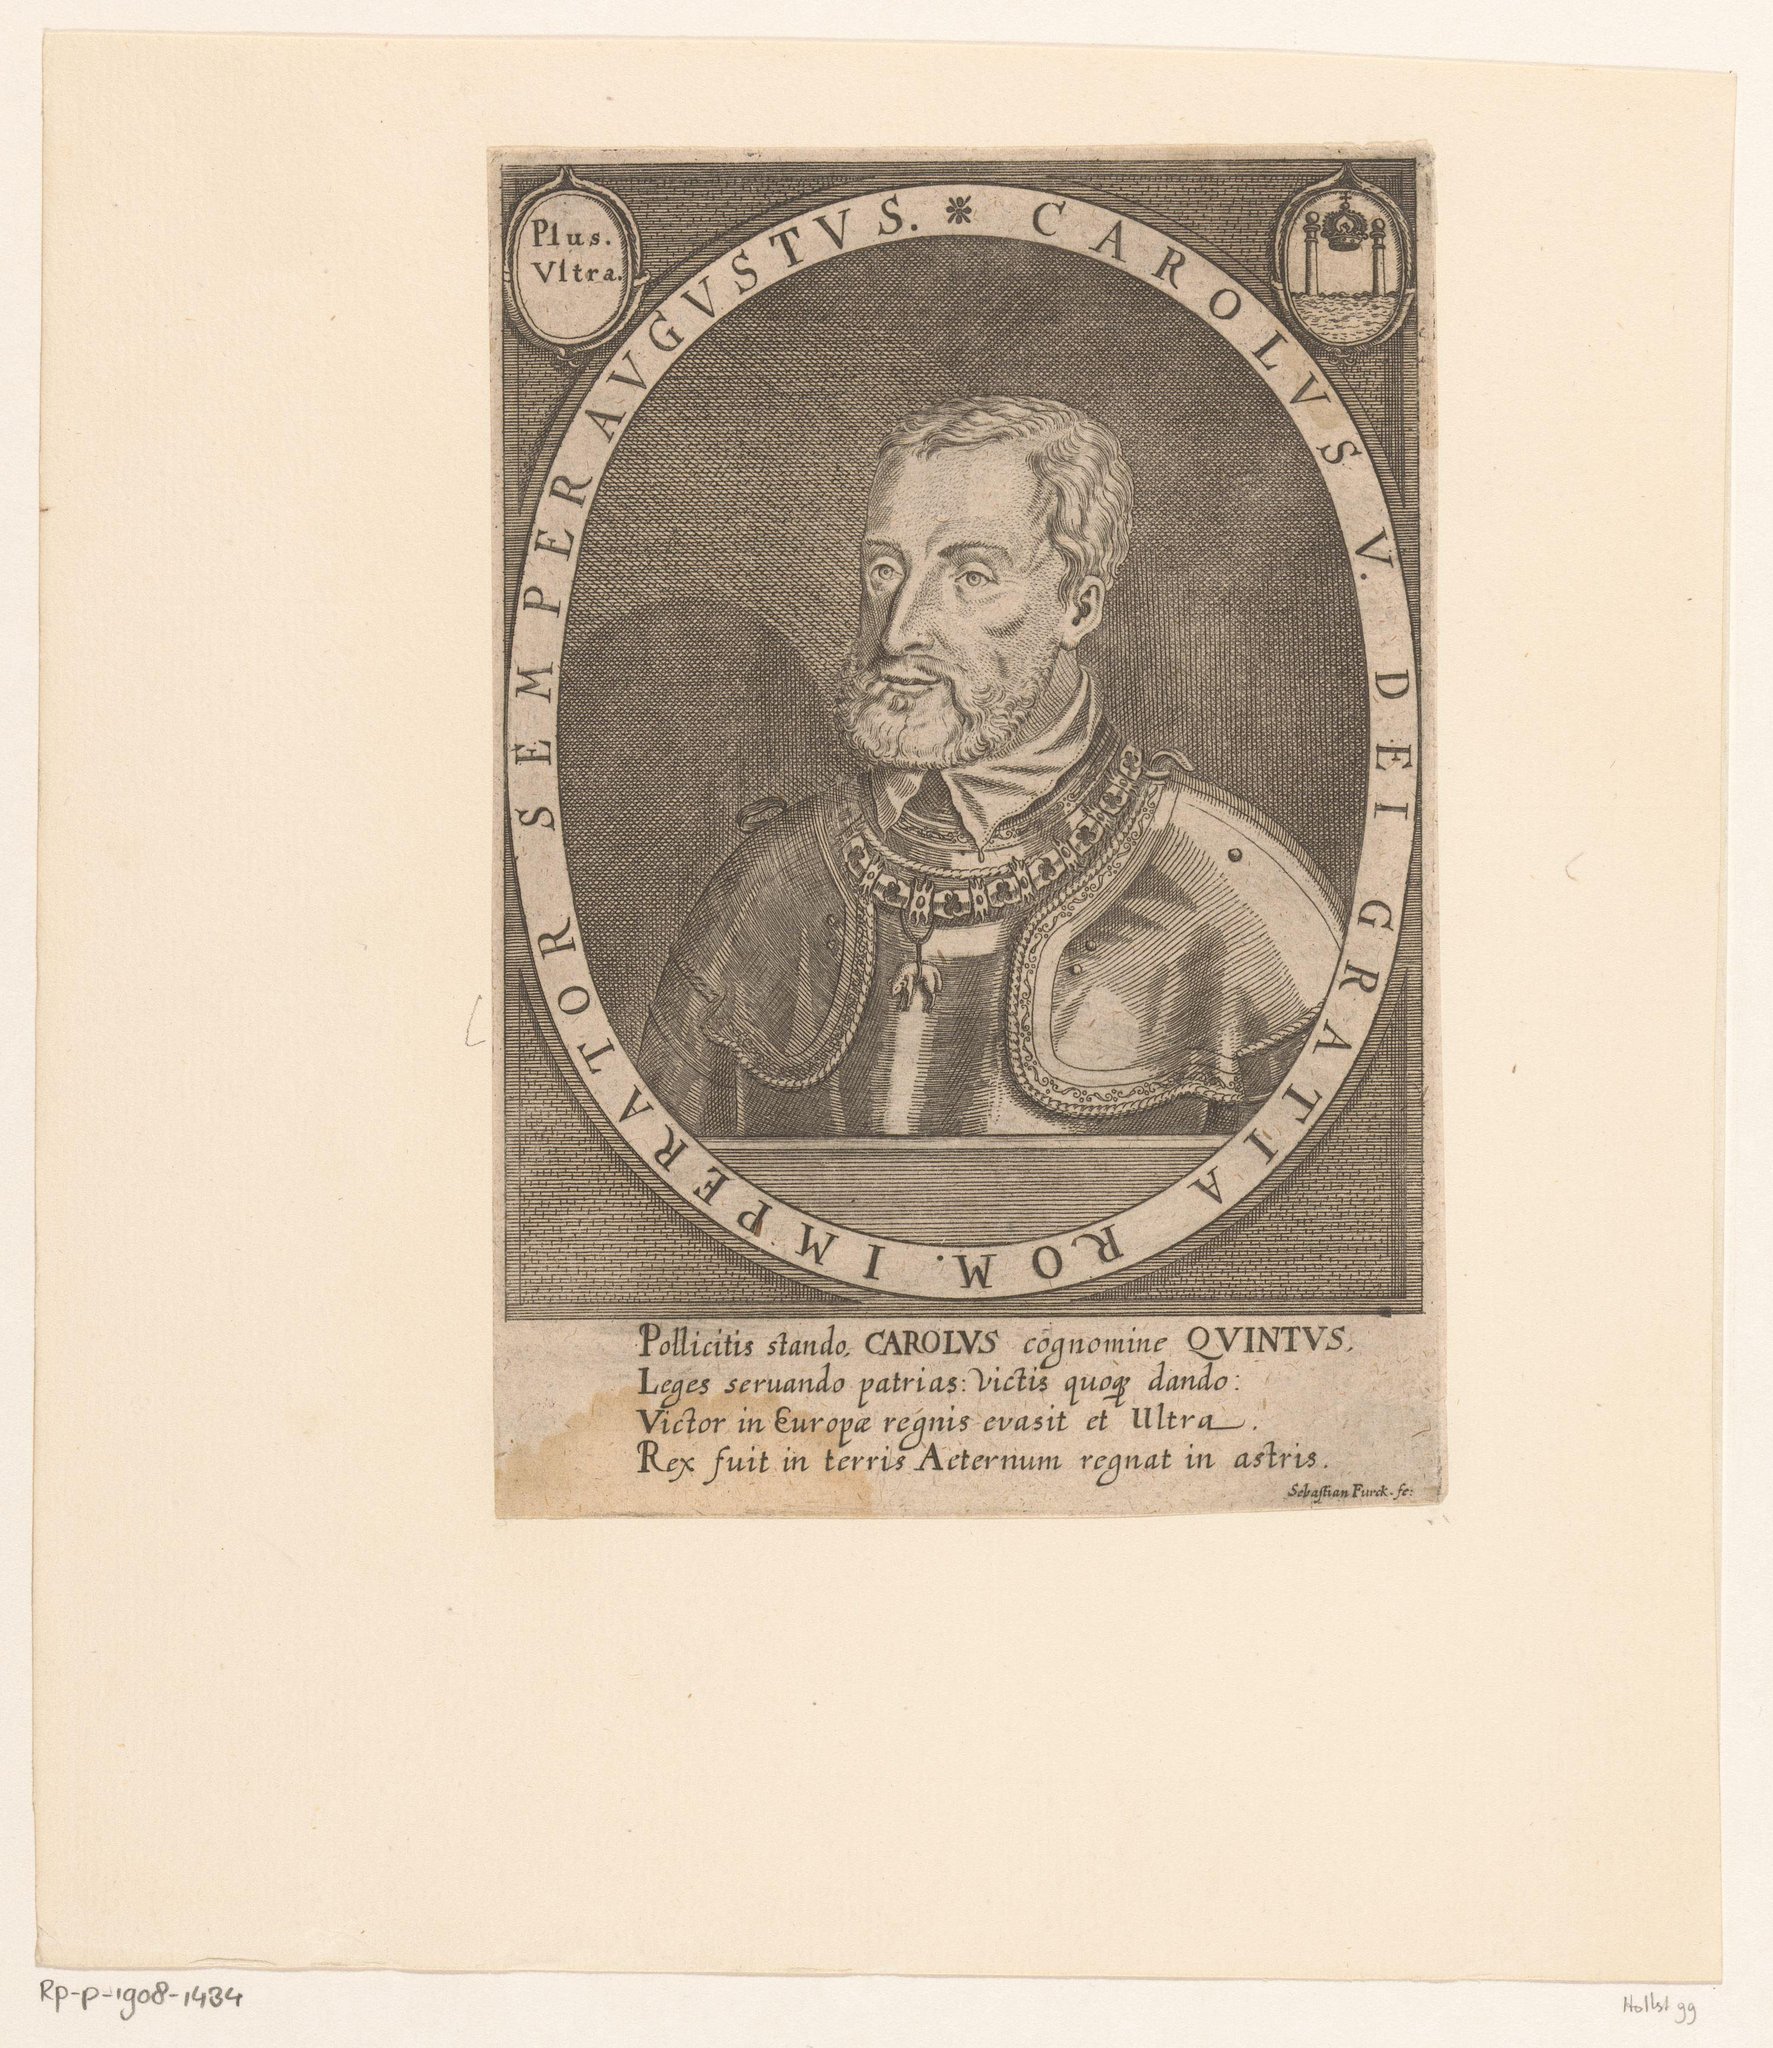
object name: print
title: Portret van keizer Karel V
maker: sebastian furck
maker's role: print maker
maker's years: 1600-1655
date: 1641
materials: paper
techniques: engraving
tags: ghent, charles v (holy roman emperor and king of spain), historical persons, emperor, knighthood order of the golden fleece - insignia of a knighthood order, e.g.: badge, chain (with name of order), abstract ideas and concepts (+ emblematical representation of concept)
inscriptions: collector's mark: Lugt 2228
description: Prent gebruikt voor: Helvicus, Nicolaus. Theatrum Historiae universalis Catholico Protestantium (...). Frankfurt am Main: Johann Gottfried Schönwetter, 1641.